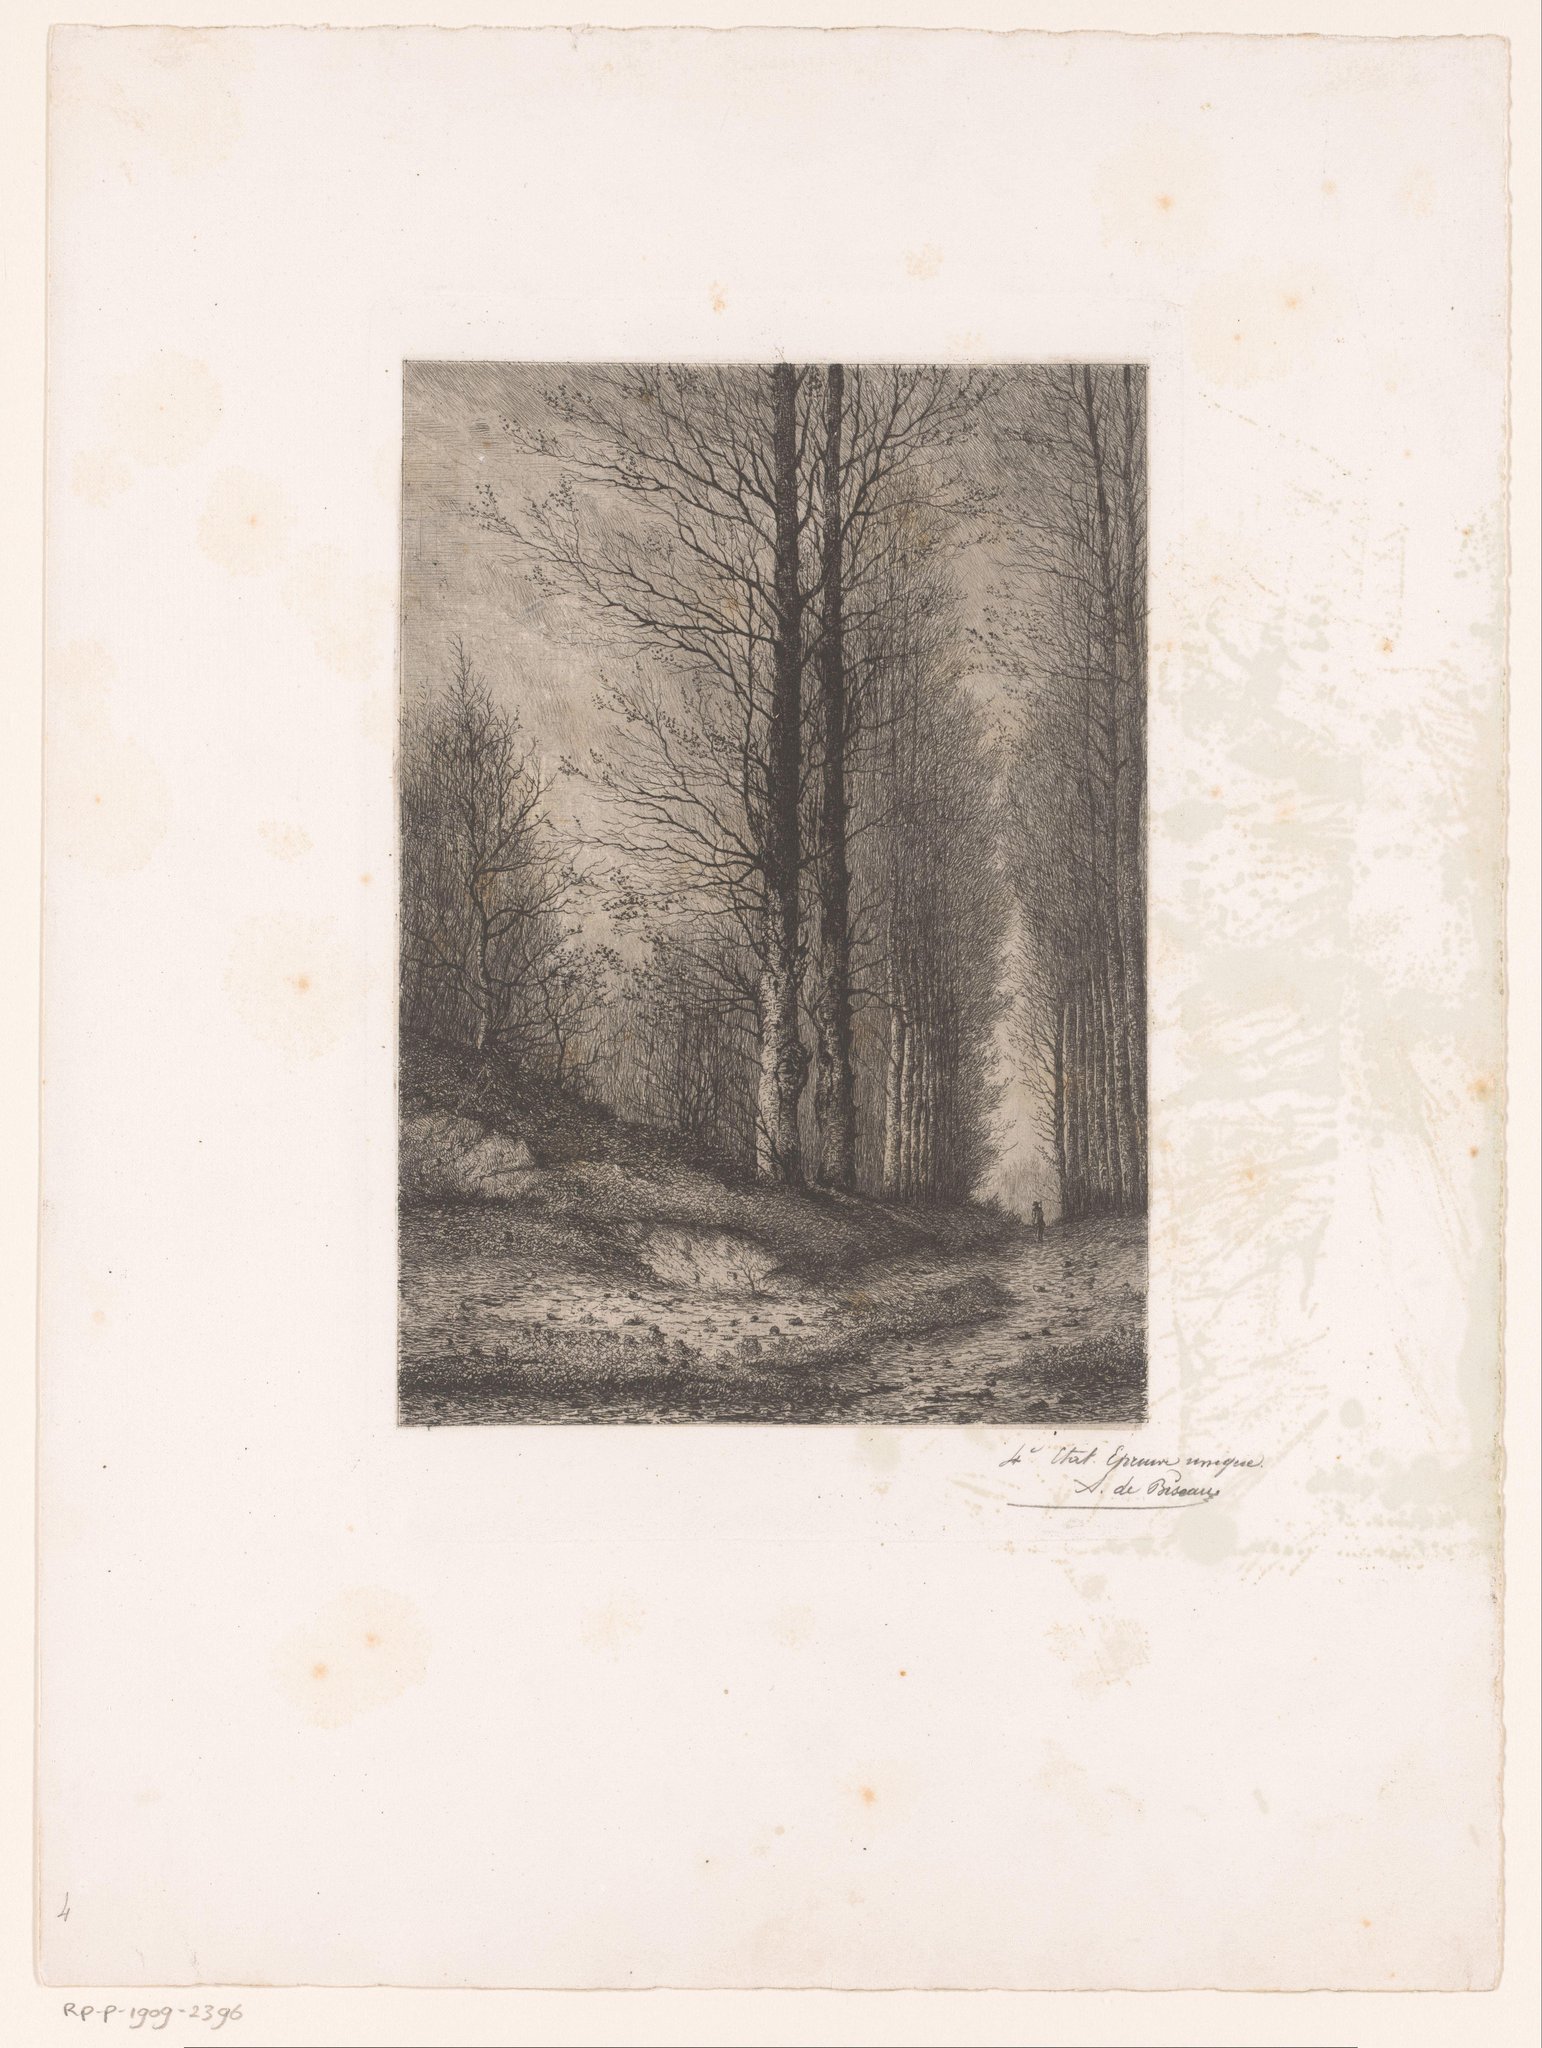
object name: print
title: Boslaan met ruiter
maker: aristide de biseau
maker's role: print maker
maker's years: 1844-1883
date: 1873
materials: paper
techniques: etching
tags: horse throwing rider, trees: beech, forest path or lane, autumn, fall, 'autumnus'; 'autunno' (ripa)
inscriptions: collector's mark: Lugt 2228, inscription: ‘4e Etat Epreuve unique’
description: Een latere staat van deze prent is gebruikt in: Album du Journal des Beaux-Arts. Antwerpen, s.n., 1873.